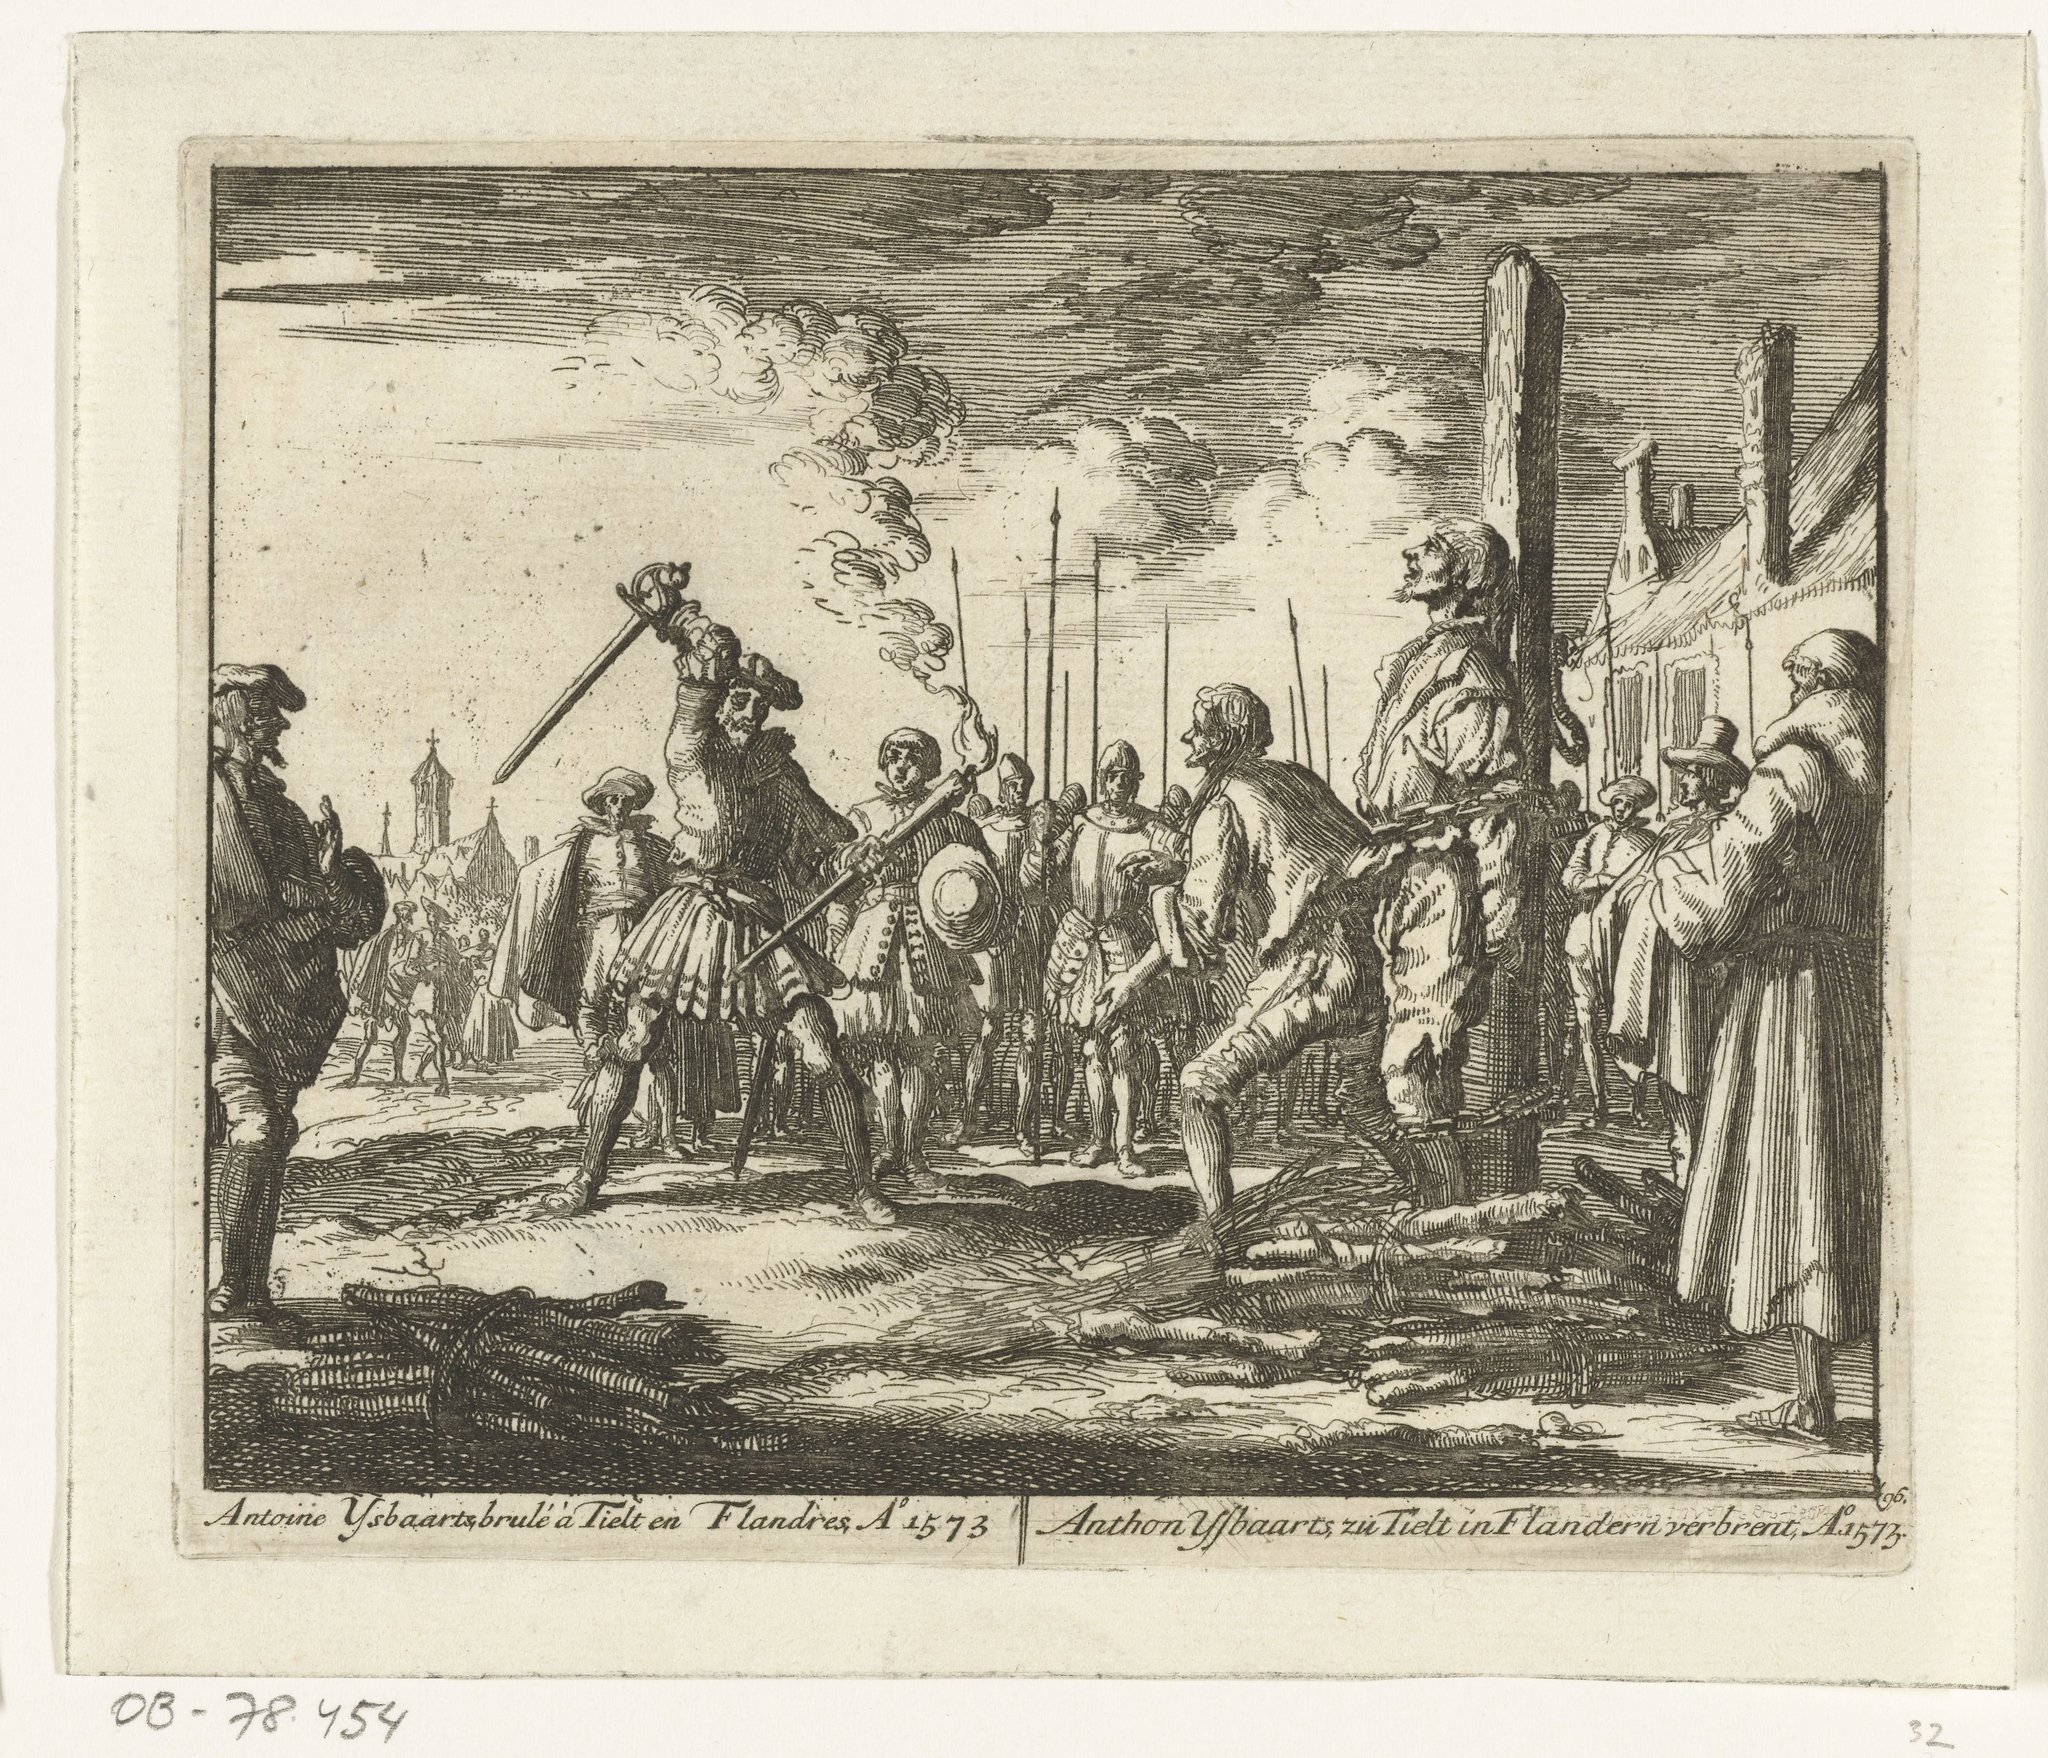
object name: print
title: Antoine Ysbaarts, brulé à Tielt en Flandres, Ao. 1573 / Anthon Ysbaarts, zu Tielt in Flandern verbrent, Ao. 1573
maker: jan luyken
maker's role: draughtsman, print maker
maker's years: 1649-1712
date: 1683-1685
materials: paper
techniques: etching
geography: northern netherlands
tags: execution of heretic, e.g. by burning at the stake, 'auto-da-fé', violent death by burning at the stake; pyre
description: De prenten in deze tweede staat gebruikt als illustratie voor: Theatre des martyrs, depuis la mort de J. Christ jusqu'à present (...). = Schau-buhne der Martyrer, P. van der Aa, Leiden ca. 1715, nr. 96. De prenten zijn oorspronkelijk vervaardigd voor en eerst gebruikt in: T.J. van Bragt, Het bloedig tooneel, of Martelaers spiegel der doops-gesinde of weereloose christenen, 1685.